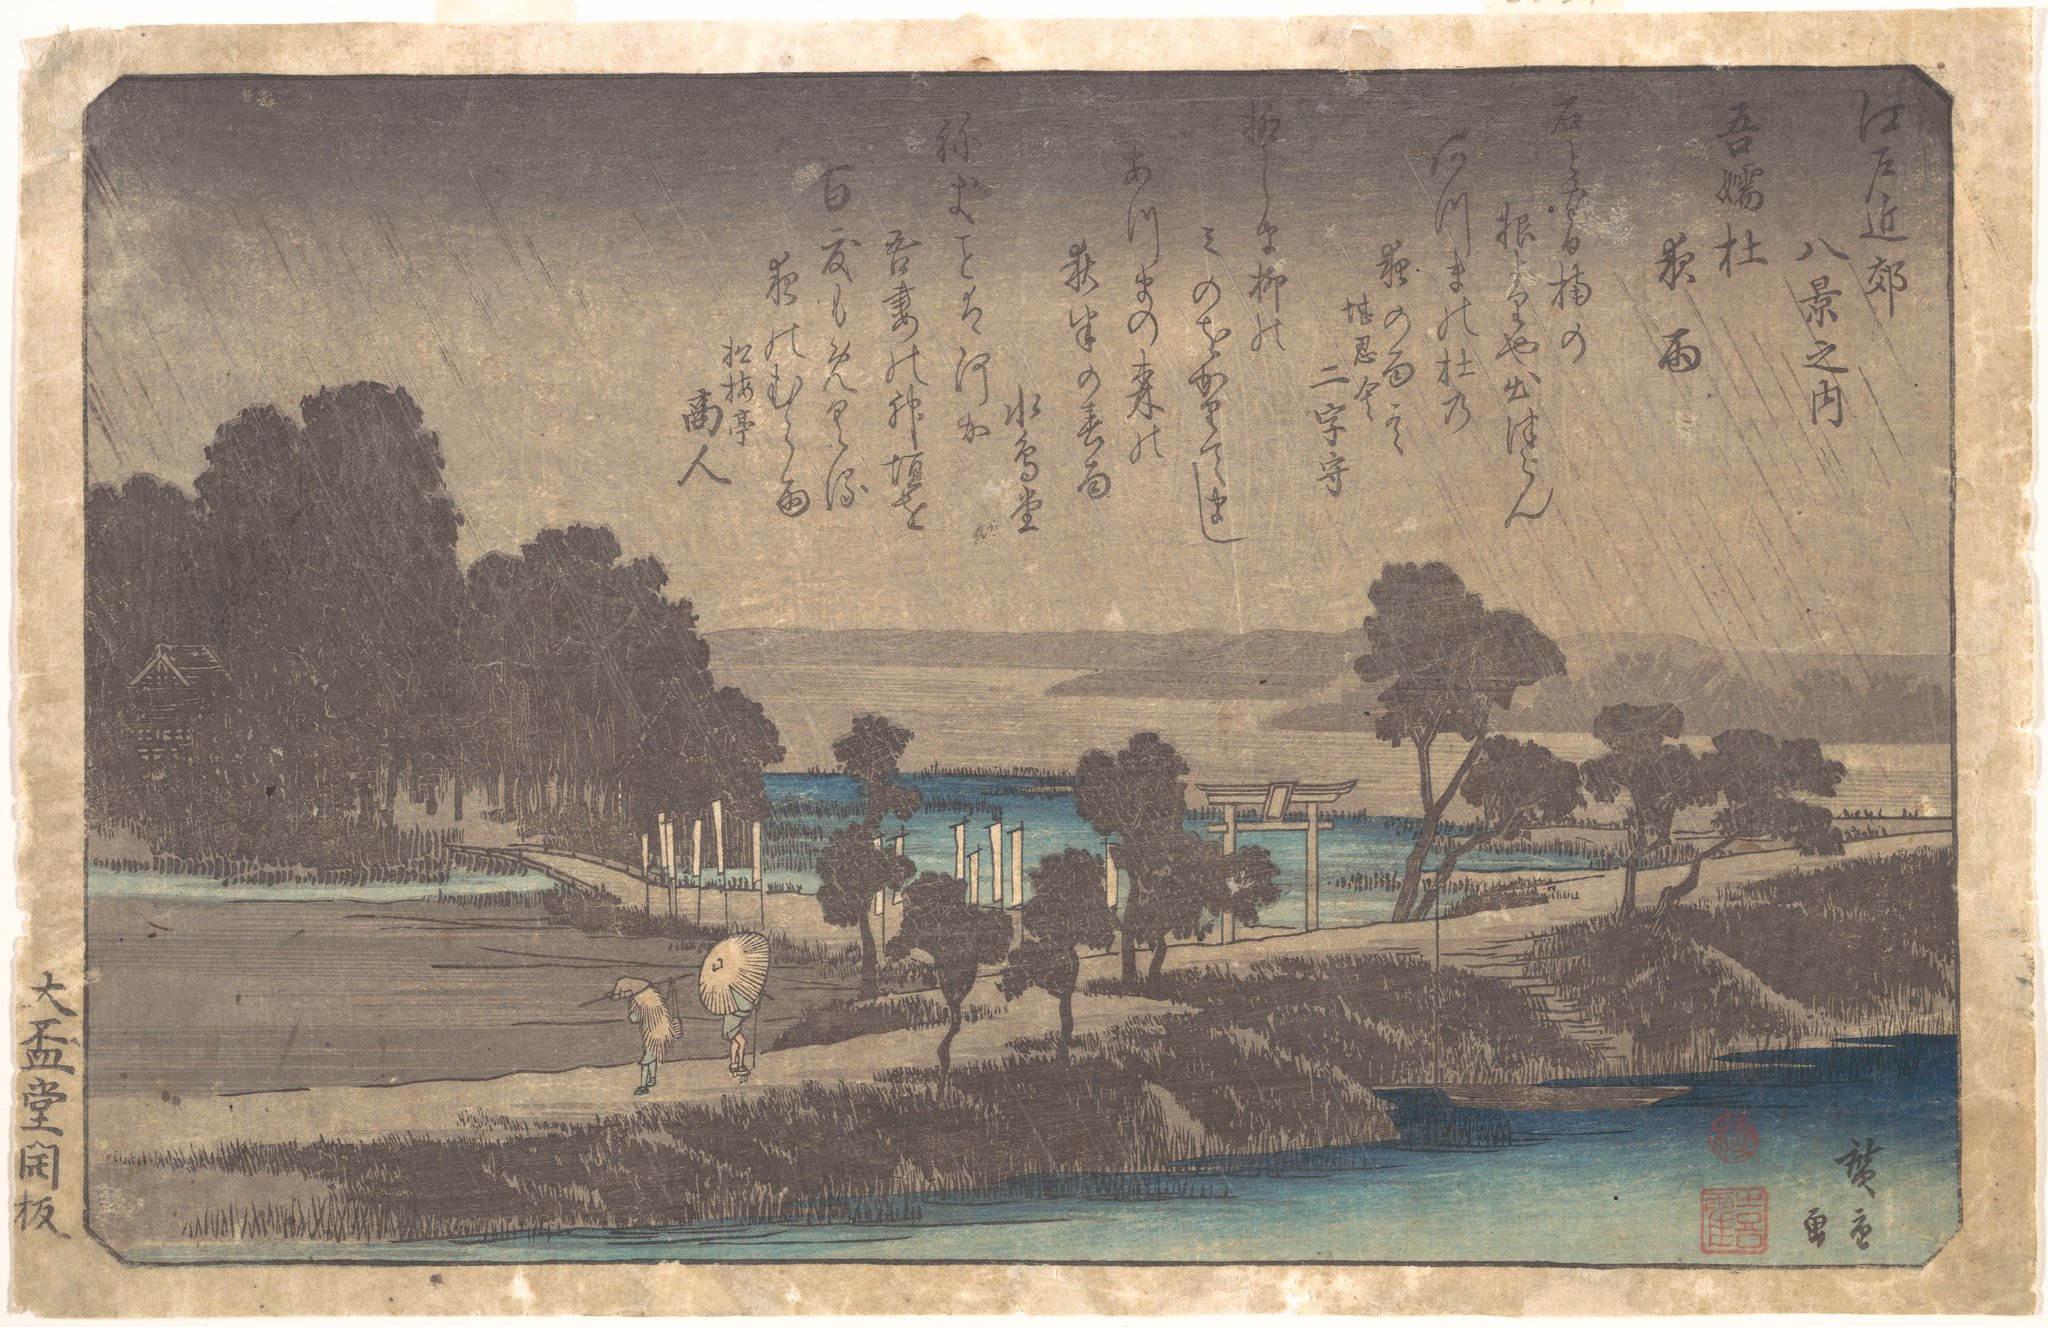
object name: print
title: Evening Rain in Azuma Wood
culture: japanese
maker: utagawa hiroshige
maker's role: artist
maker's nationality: japanese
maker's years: 1797-1858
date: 1838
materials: ink, paper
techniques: woodblock print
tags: landscapes,trees,rain